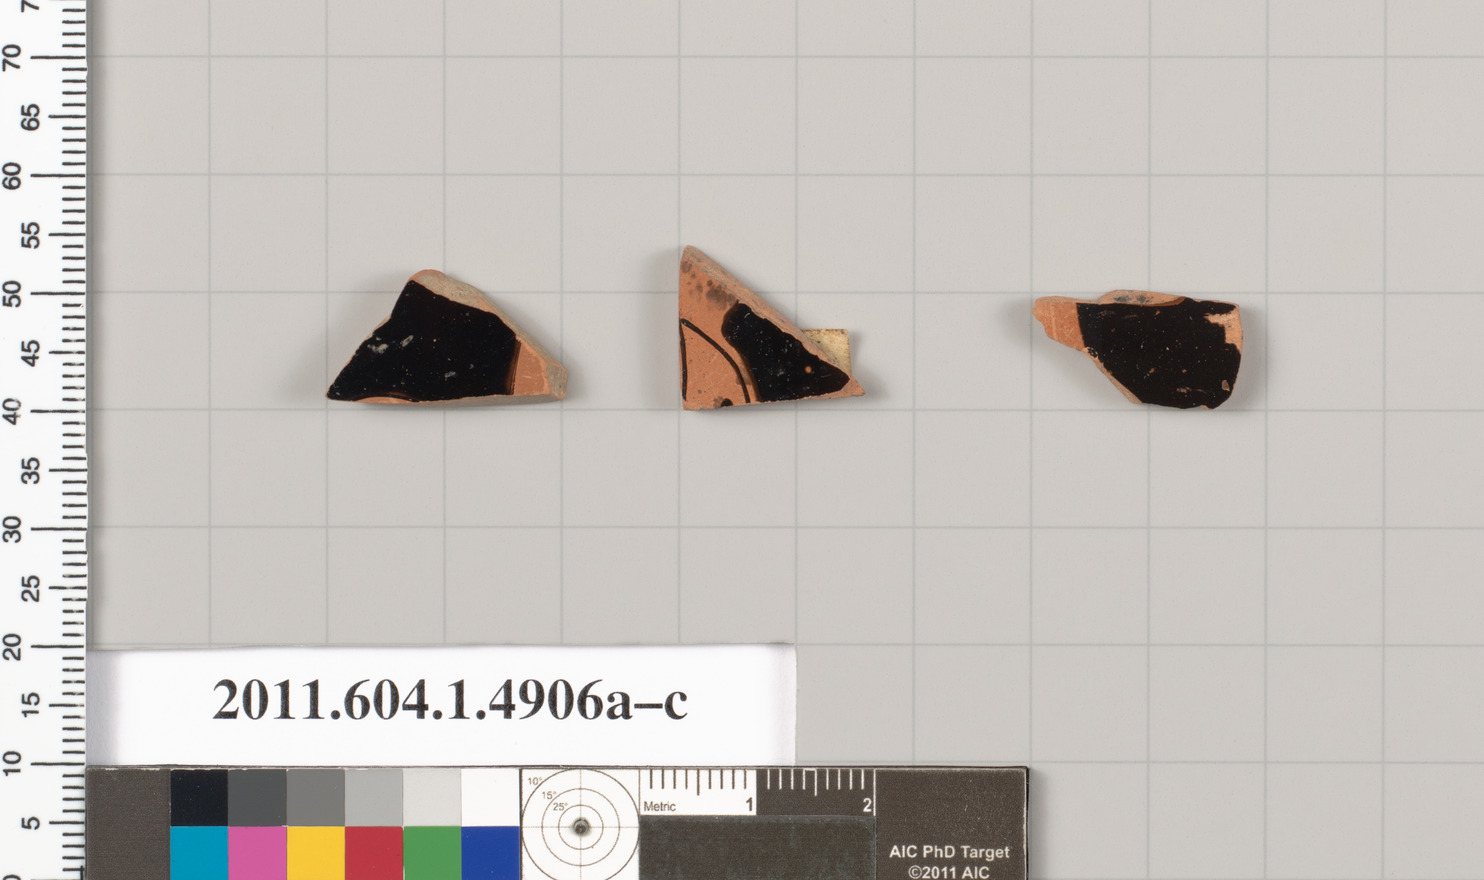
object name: kylix fragment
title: Terracotta fragments of kylikes (drinking cups)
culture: greek, attic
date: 600-401 BCE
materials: terracotta